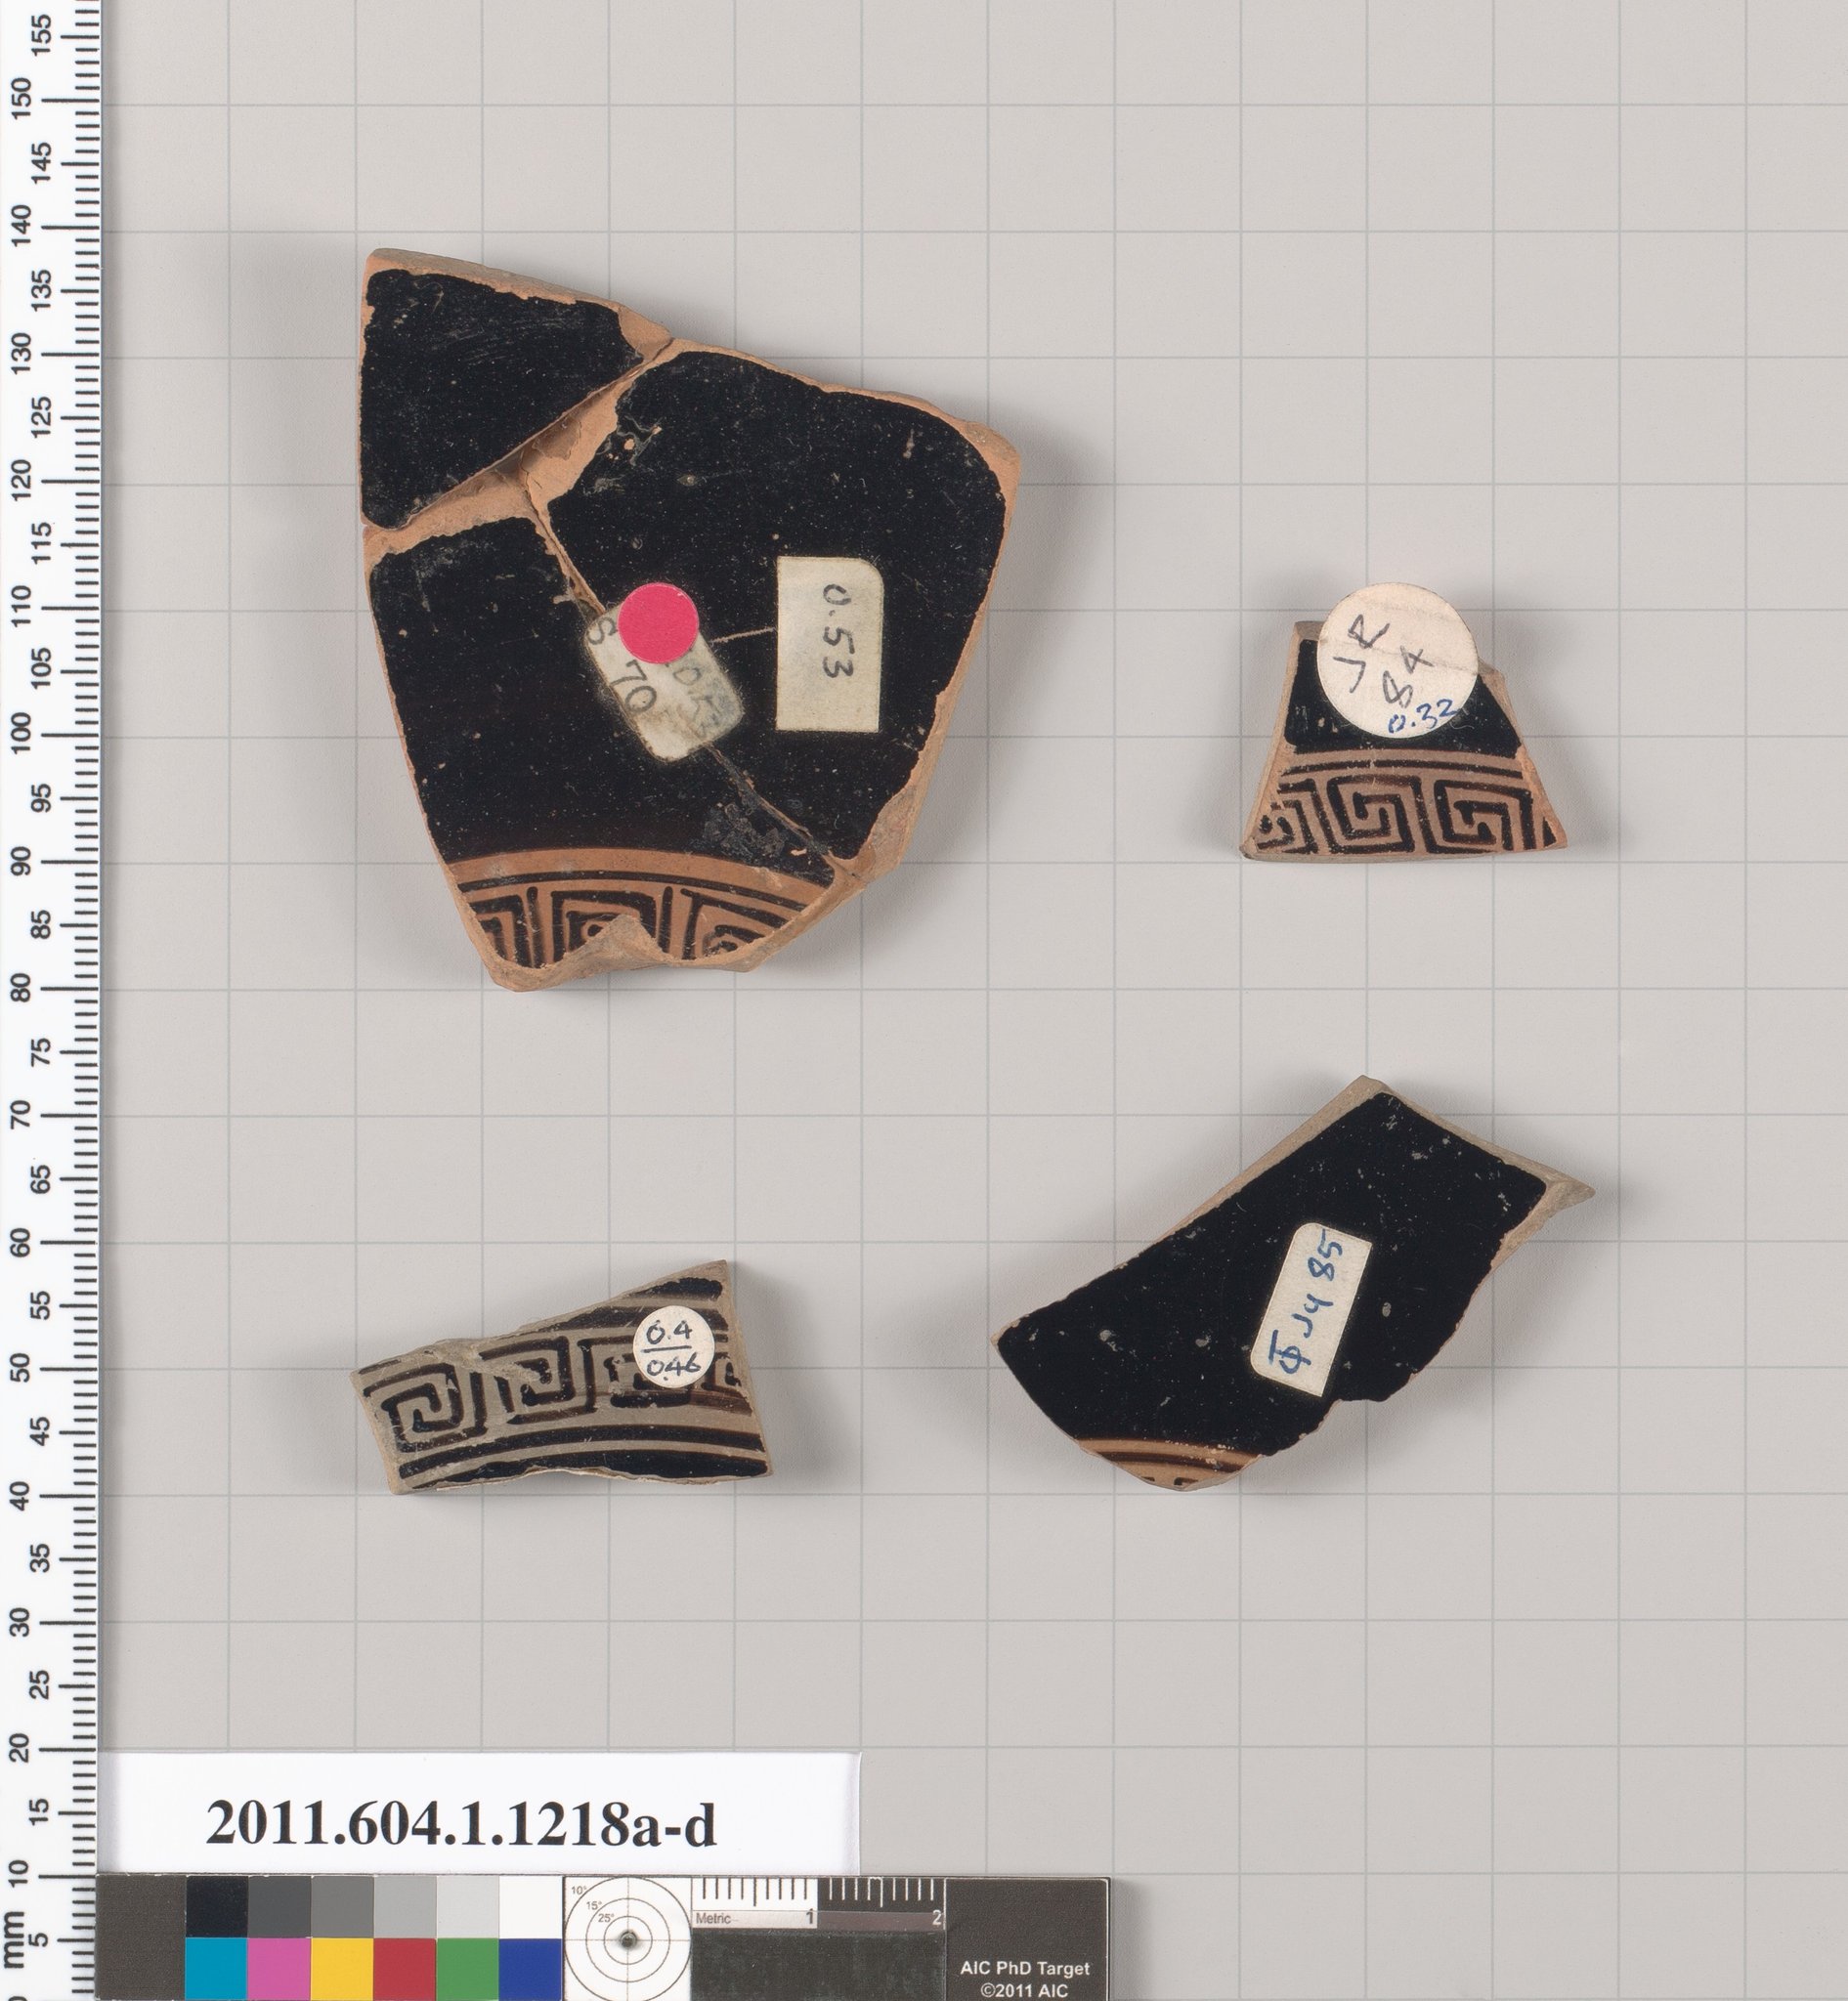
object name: kylix fragment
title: Terracotta fragments of kylikes (drinking cups)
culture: greek, attic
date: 490-480 BCE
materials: terracotta